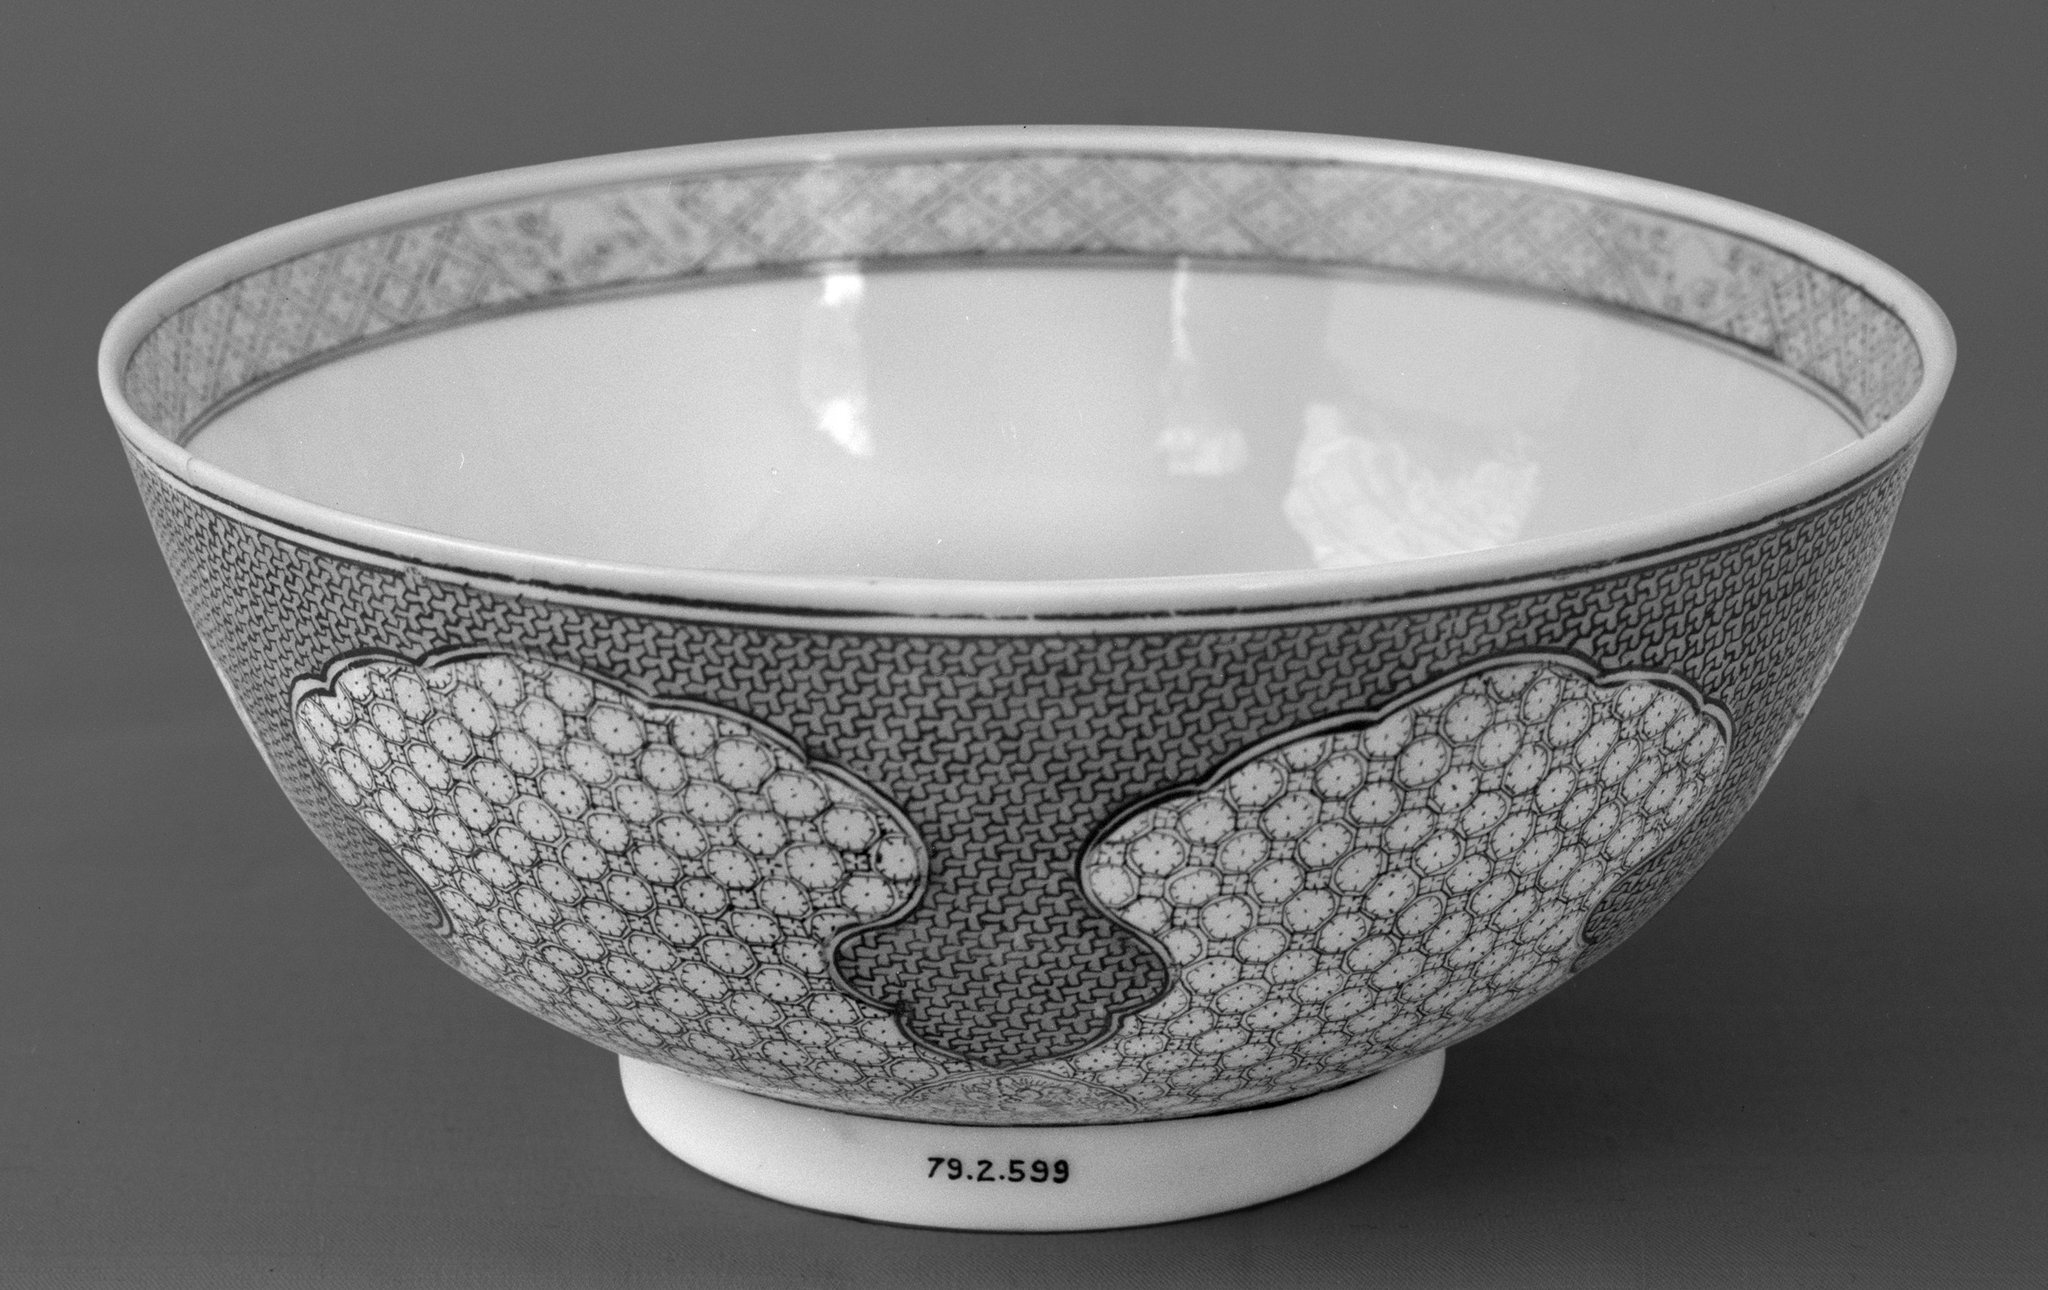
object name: bowl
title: Bowl with landscape and geometric patterns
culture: chinese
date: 1701-1800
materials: enamel, porcelain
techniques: overglaze, painting, polychrome